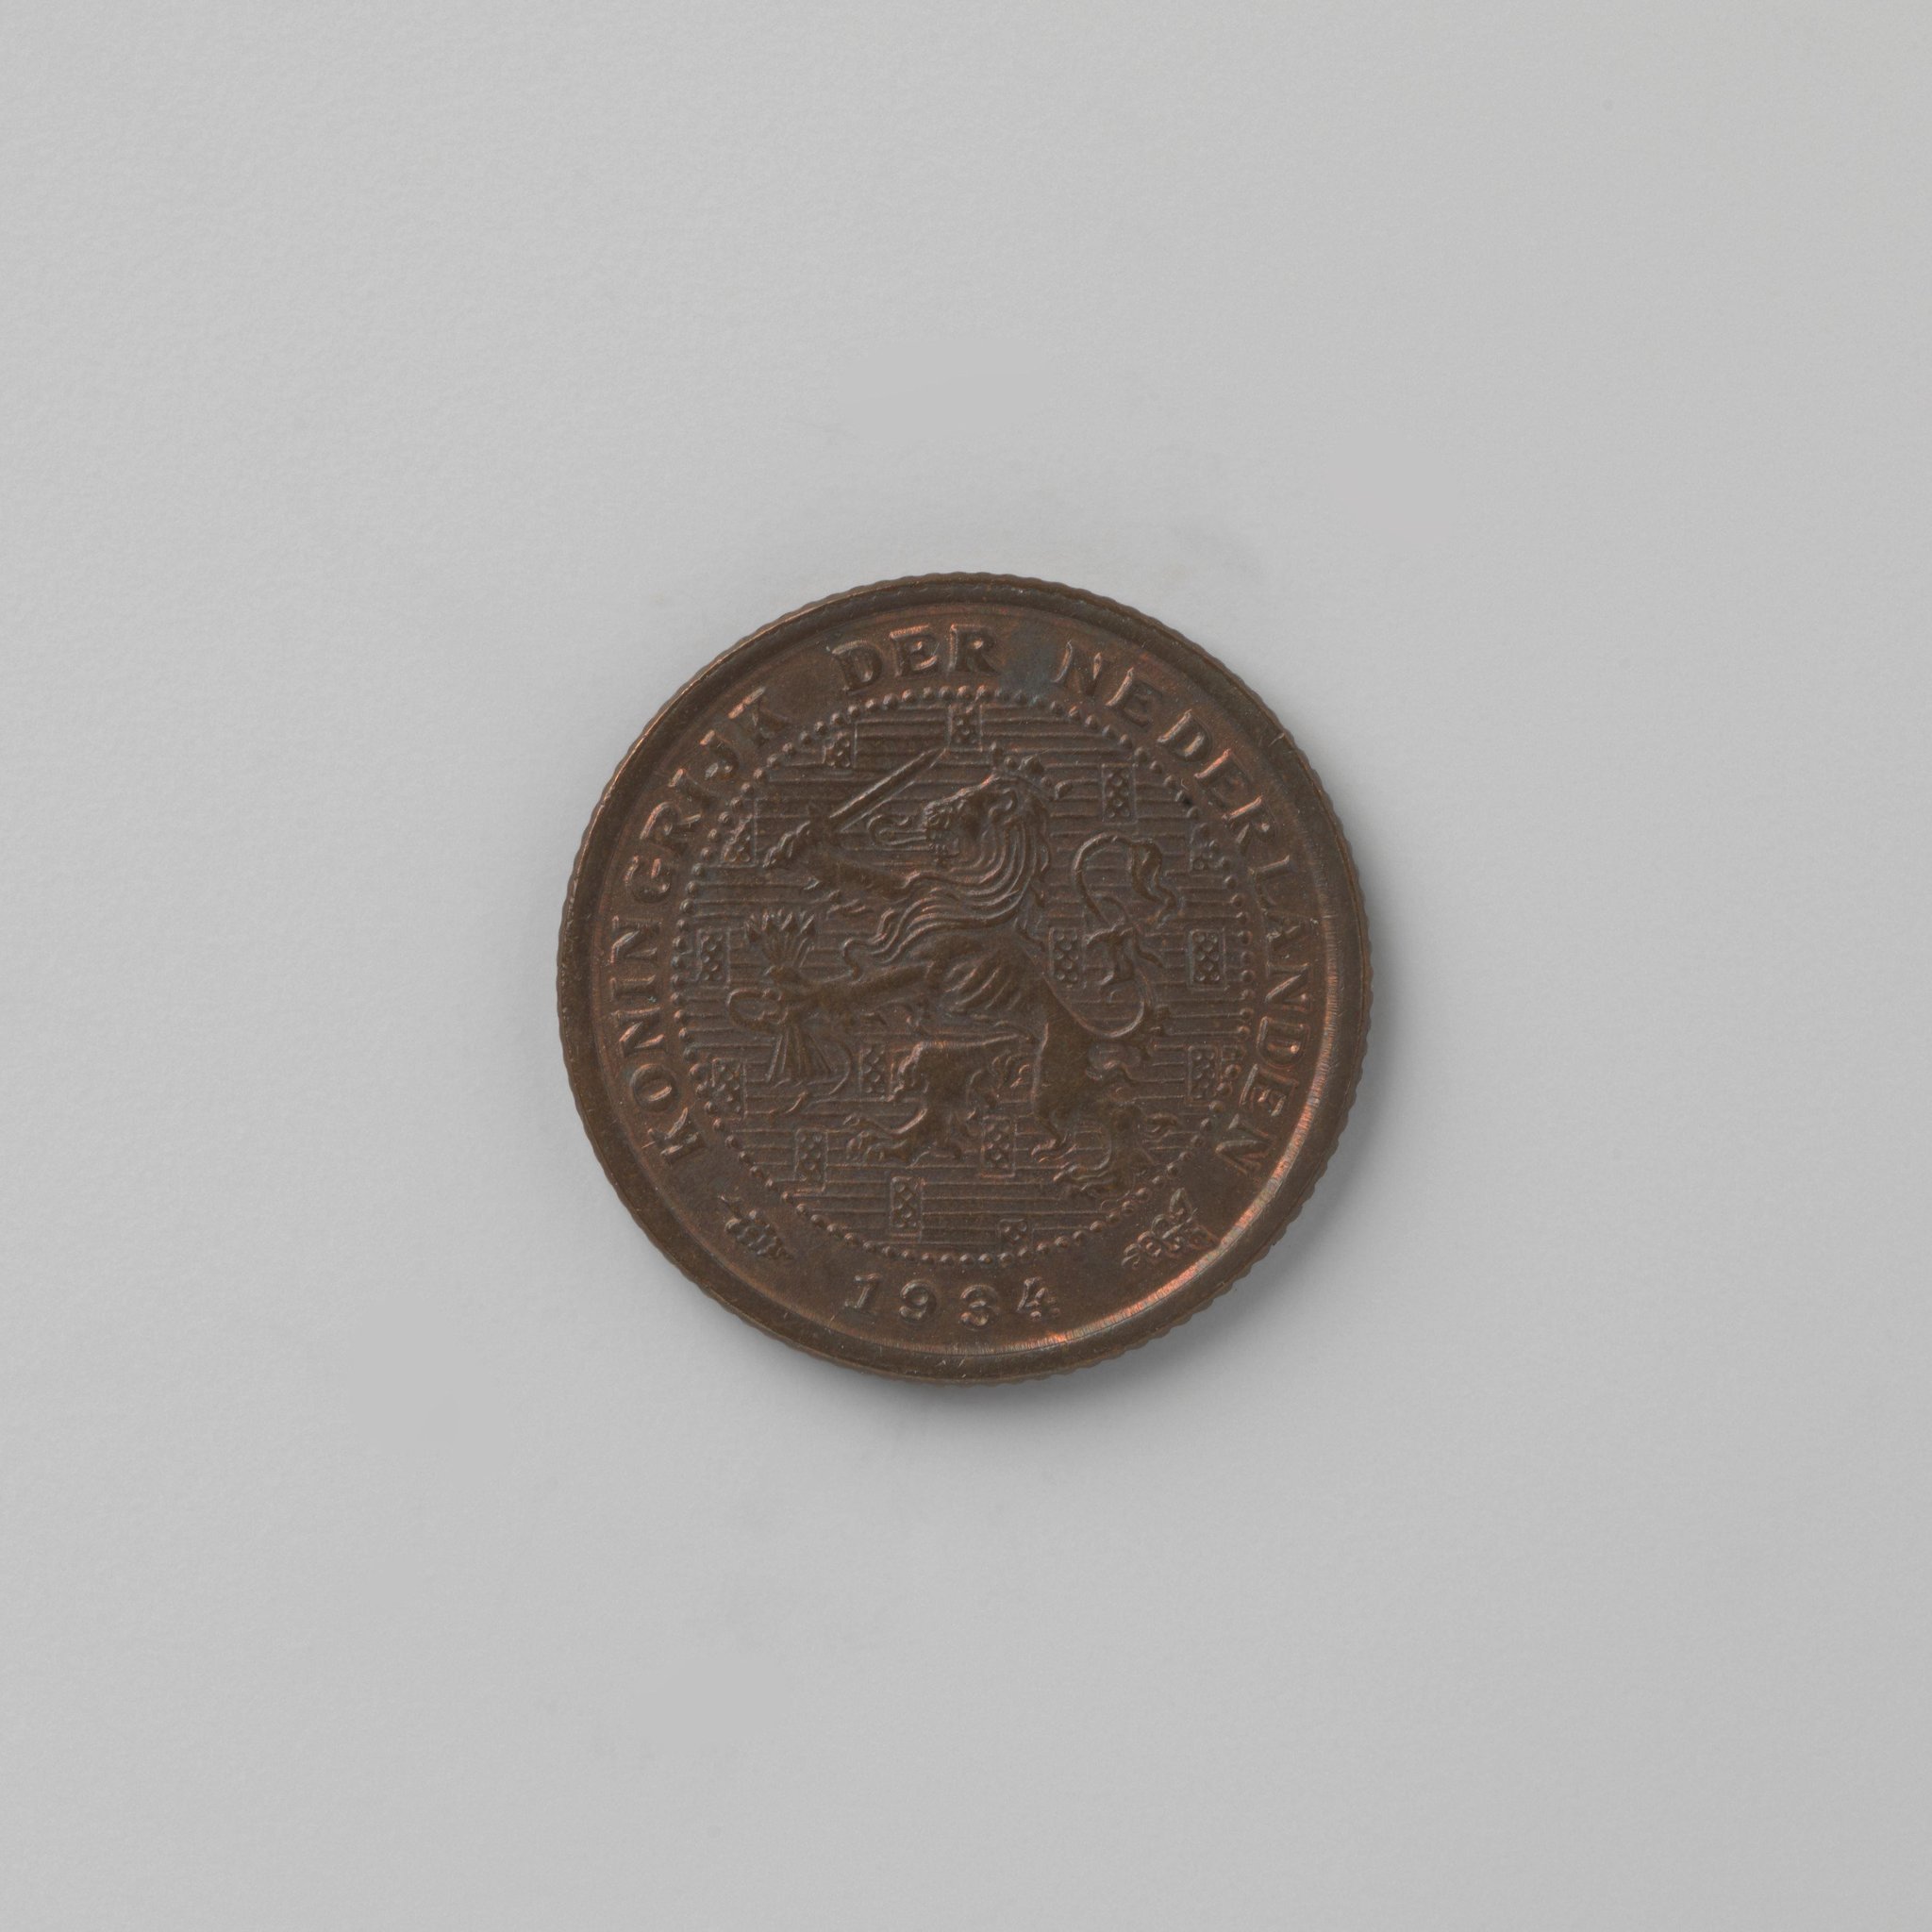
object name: coin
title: Nederland, ½ cent,1934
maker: wilhelmina of the netherlands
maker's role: print maker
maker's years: 1880-1962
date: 1934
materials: bronze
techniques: striking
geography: utrecht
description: Bronzen munt. Voorzijde: in een veld rijkswapen. Jaartal onderaan in omschrift. Keerzijde: binnen twee samengebonden oranjetakken waarde-aanduiding ½ cent. Kartelrand.